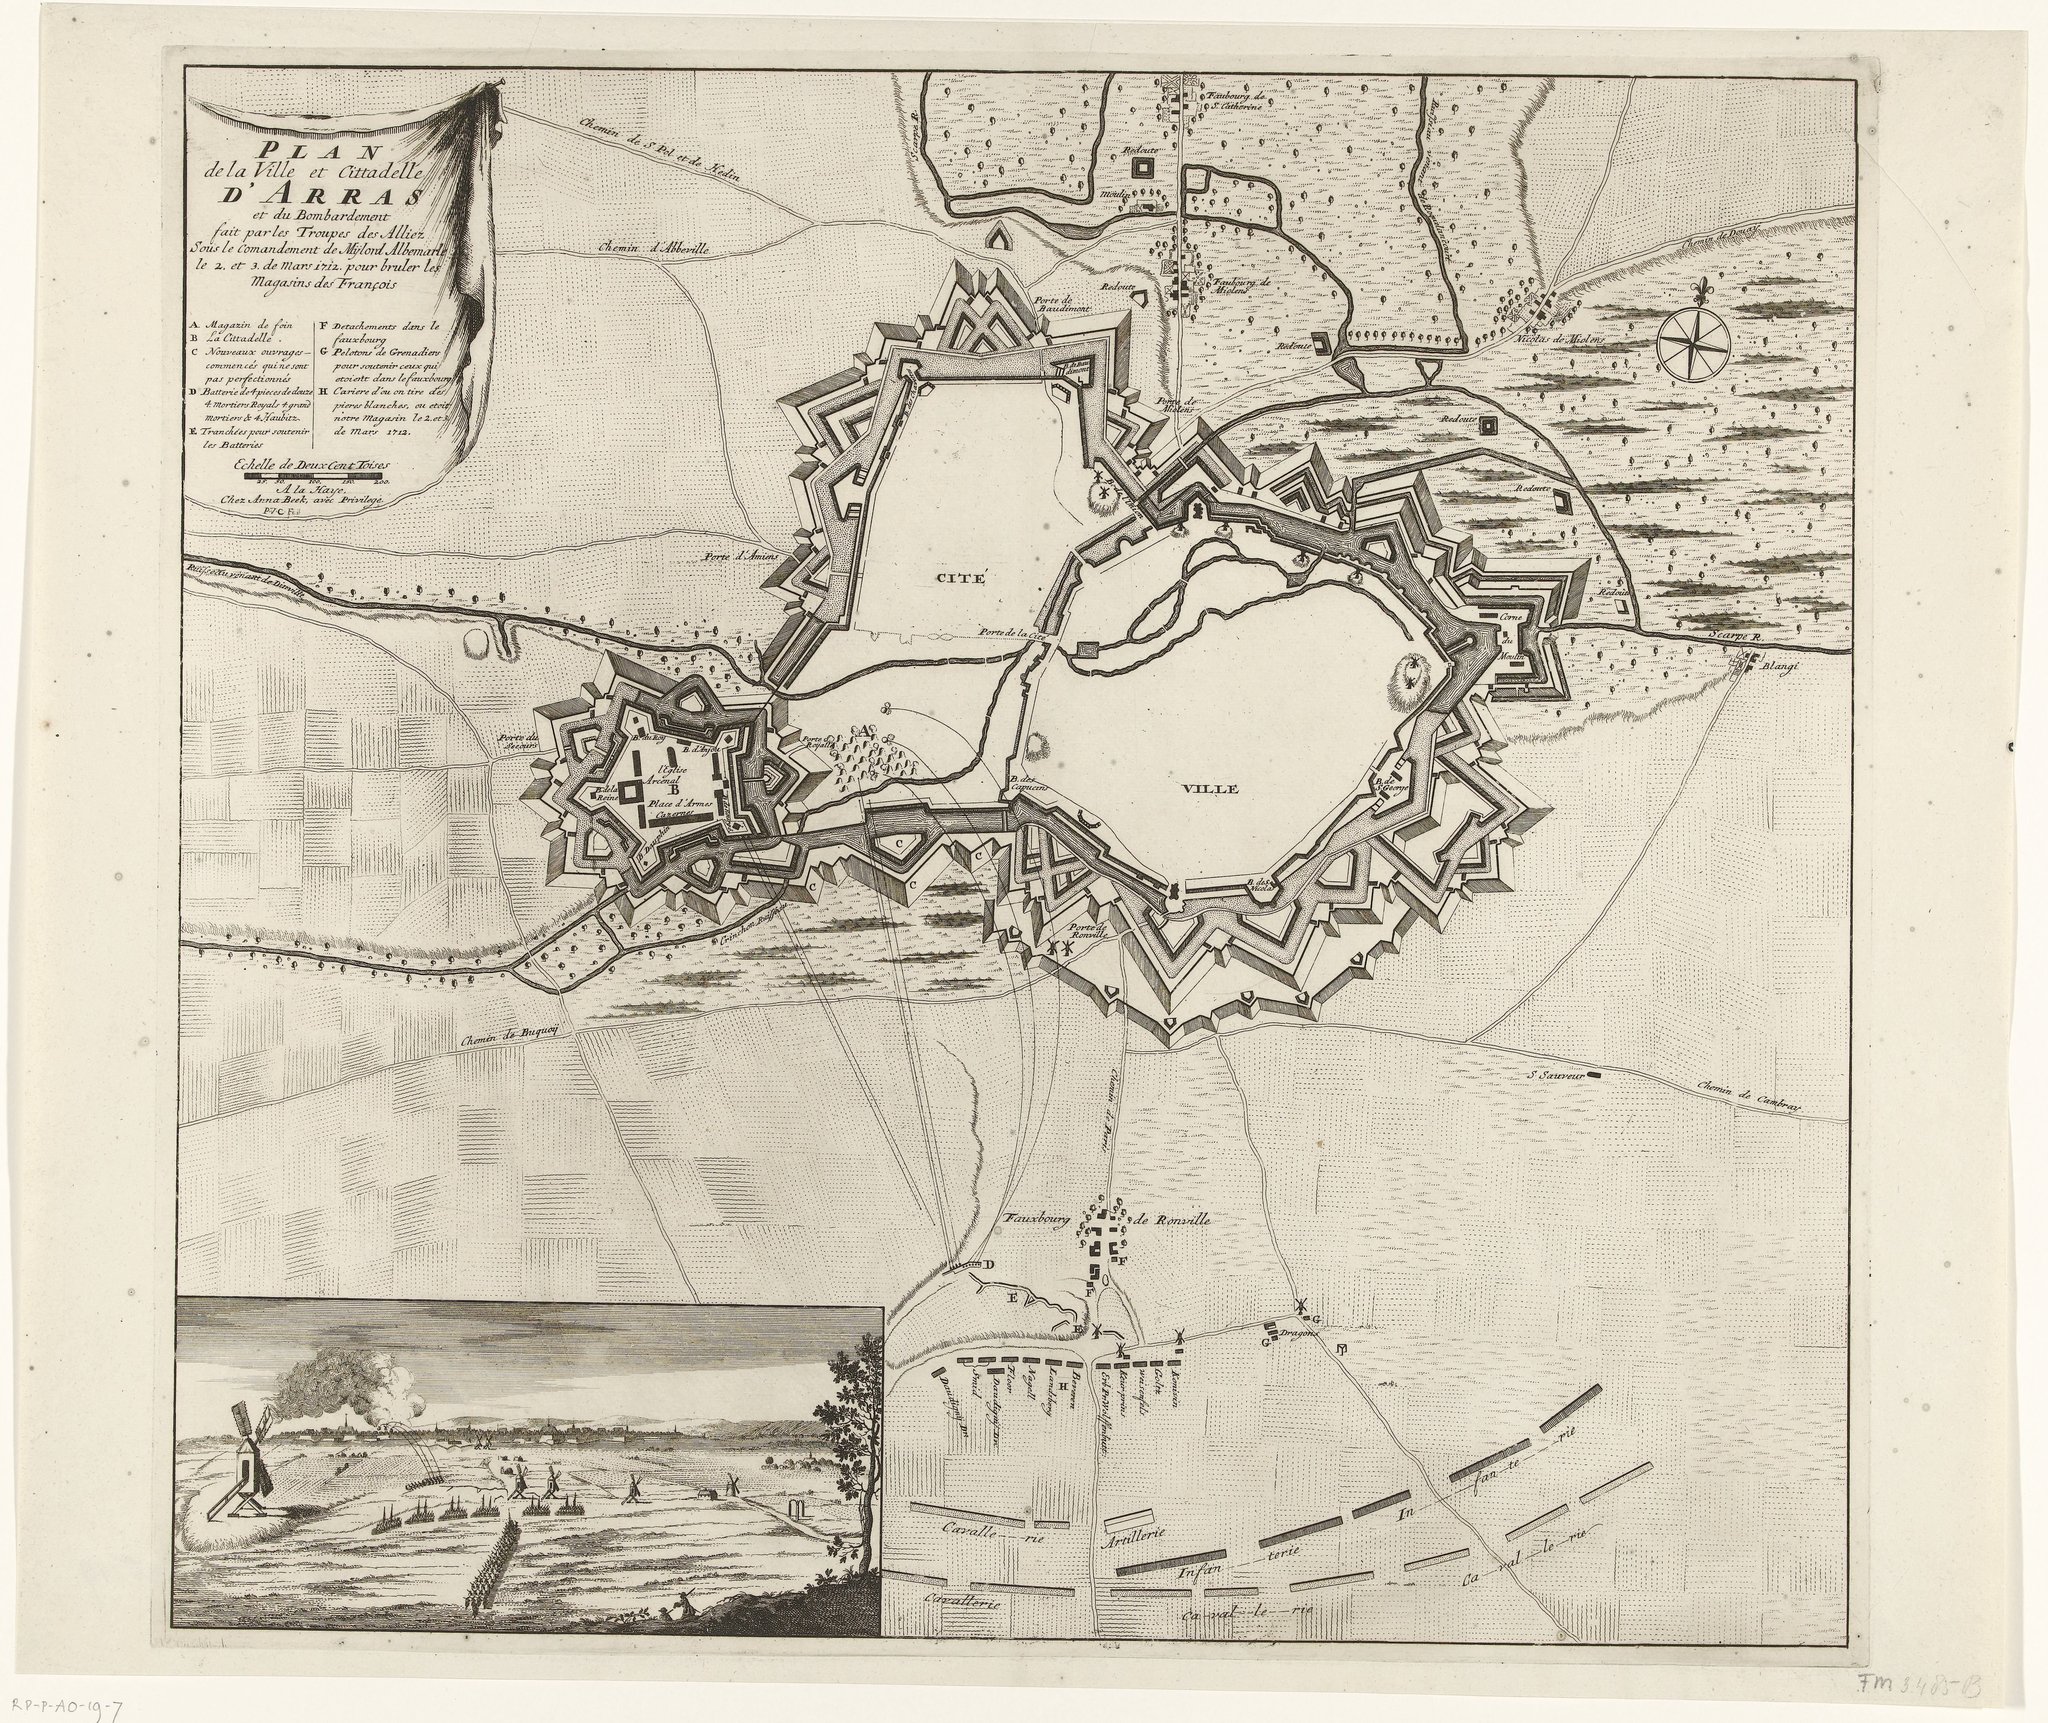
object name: map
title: Plan de la Ville et Cittadelle d'Arras et du Bombardement fait par les Troupes des Alliez Sous le Comandement de Mylord Albemarle le 2. et 3. de Mars 1712. pour bruler les Magasins des François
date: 1712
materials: paper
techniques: etching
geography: the hague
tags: bombardment ~ siege, maps of cities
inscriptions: collector's mark: Lugt 2228, collector's mark: Lugt 195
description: Plattegrond met het bombardement van Arras (Atrecht) door de Geallieerden onder de graaf van Albemarle op 2 en 3 maart 1712. Linksonder een inzet met een gezicht op de beschieting van Arras. Linksboven een cartouche met de titel en de legenda A-H in het Frans.